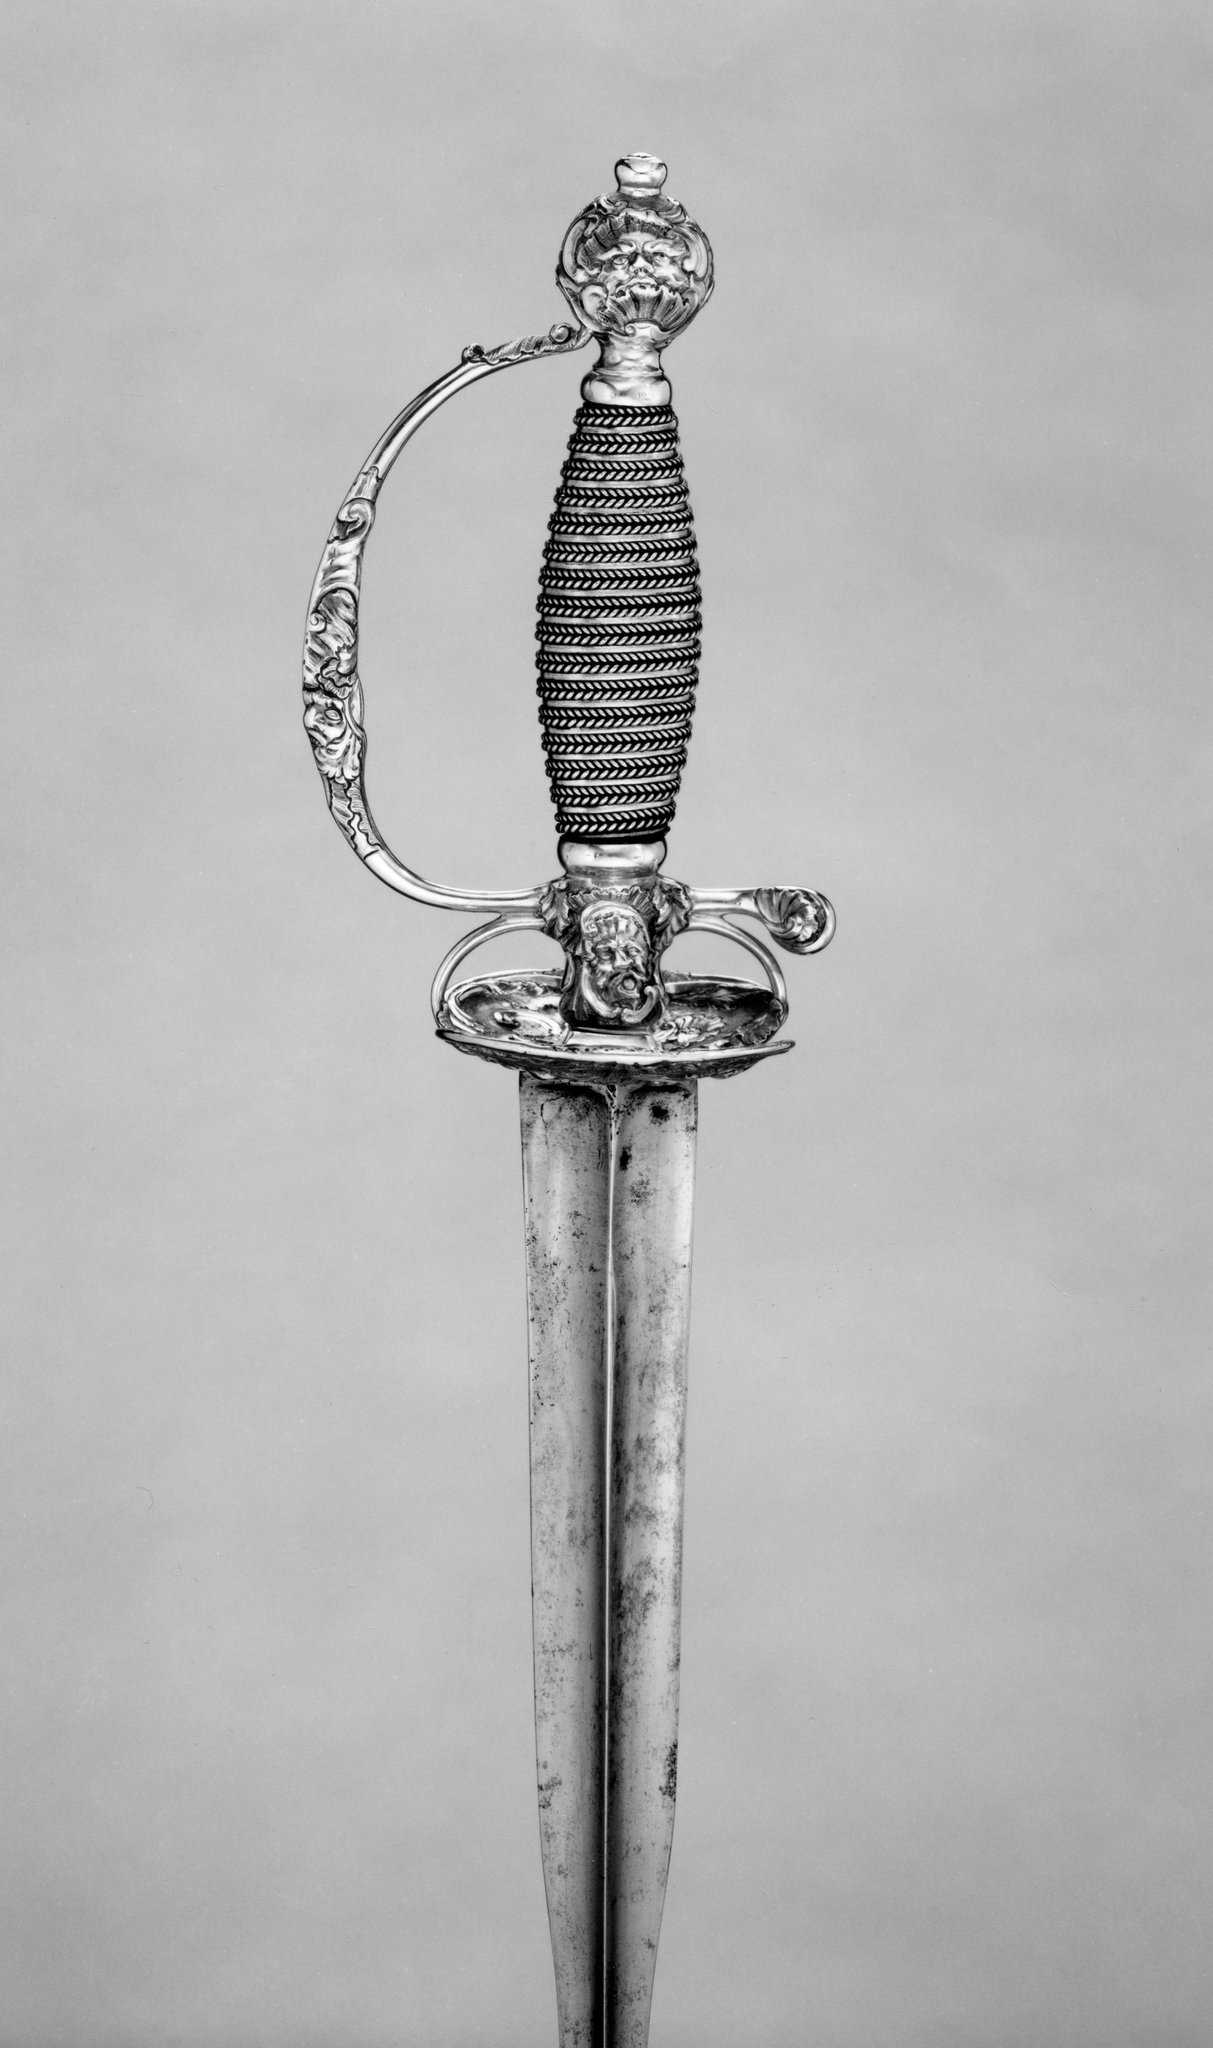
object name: smallsword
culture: british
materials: silver, steel, wood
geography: england